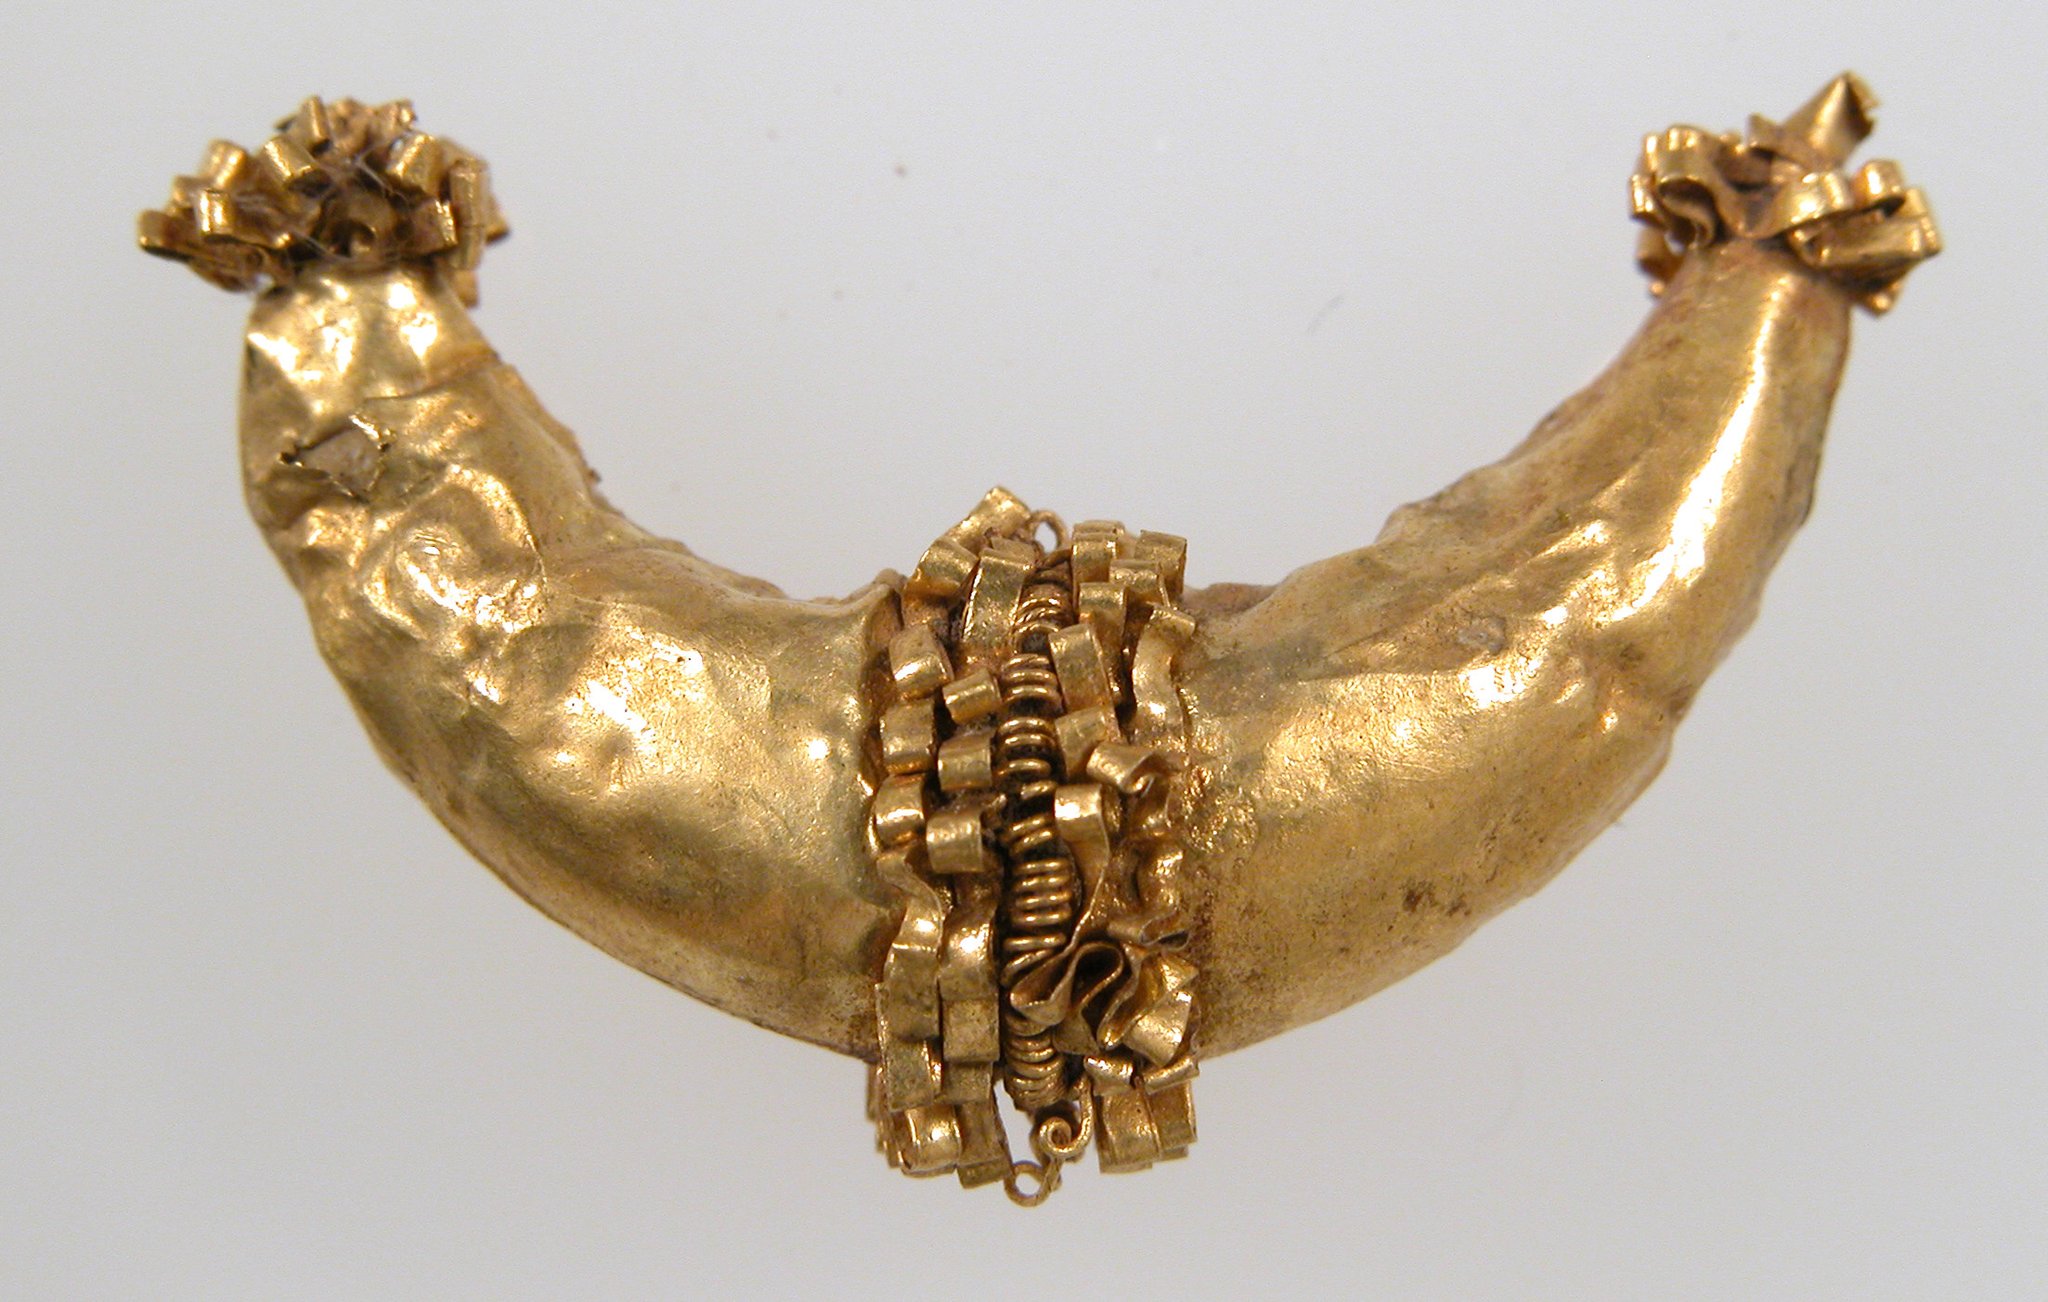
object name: earring fragment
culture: etruscan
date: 501-700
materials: gold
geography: northern france